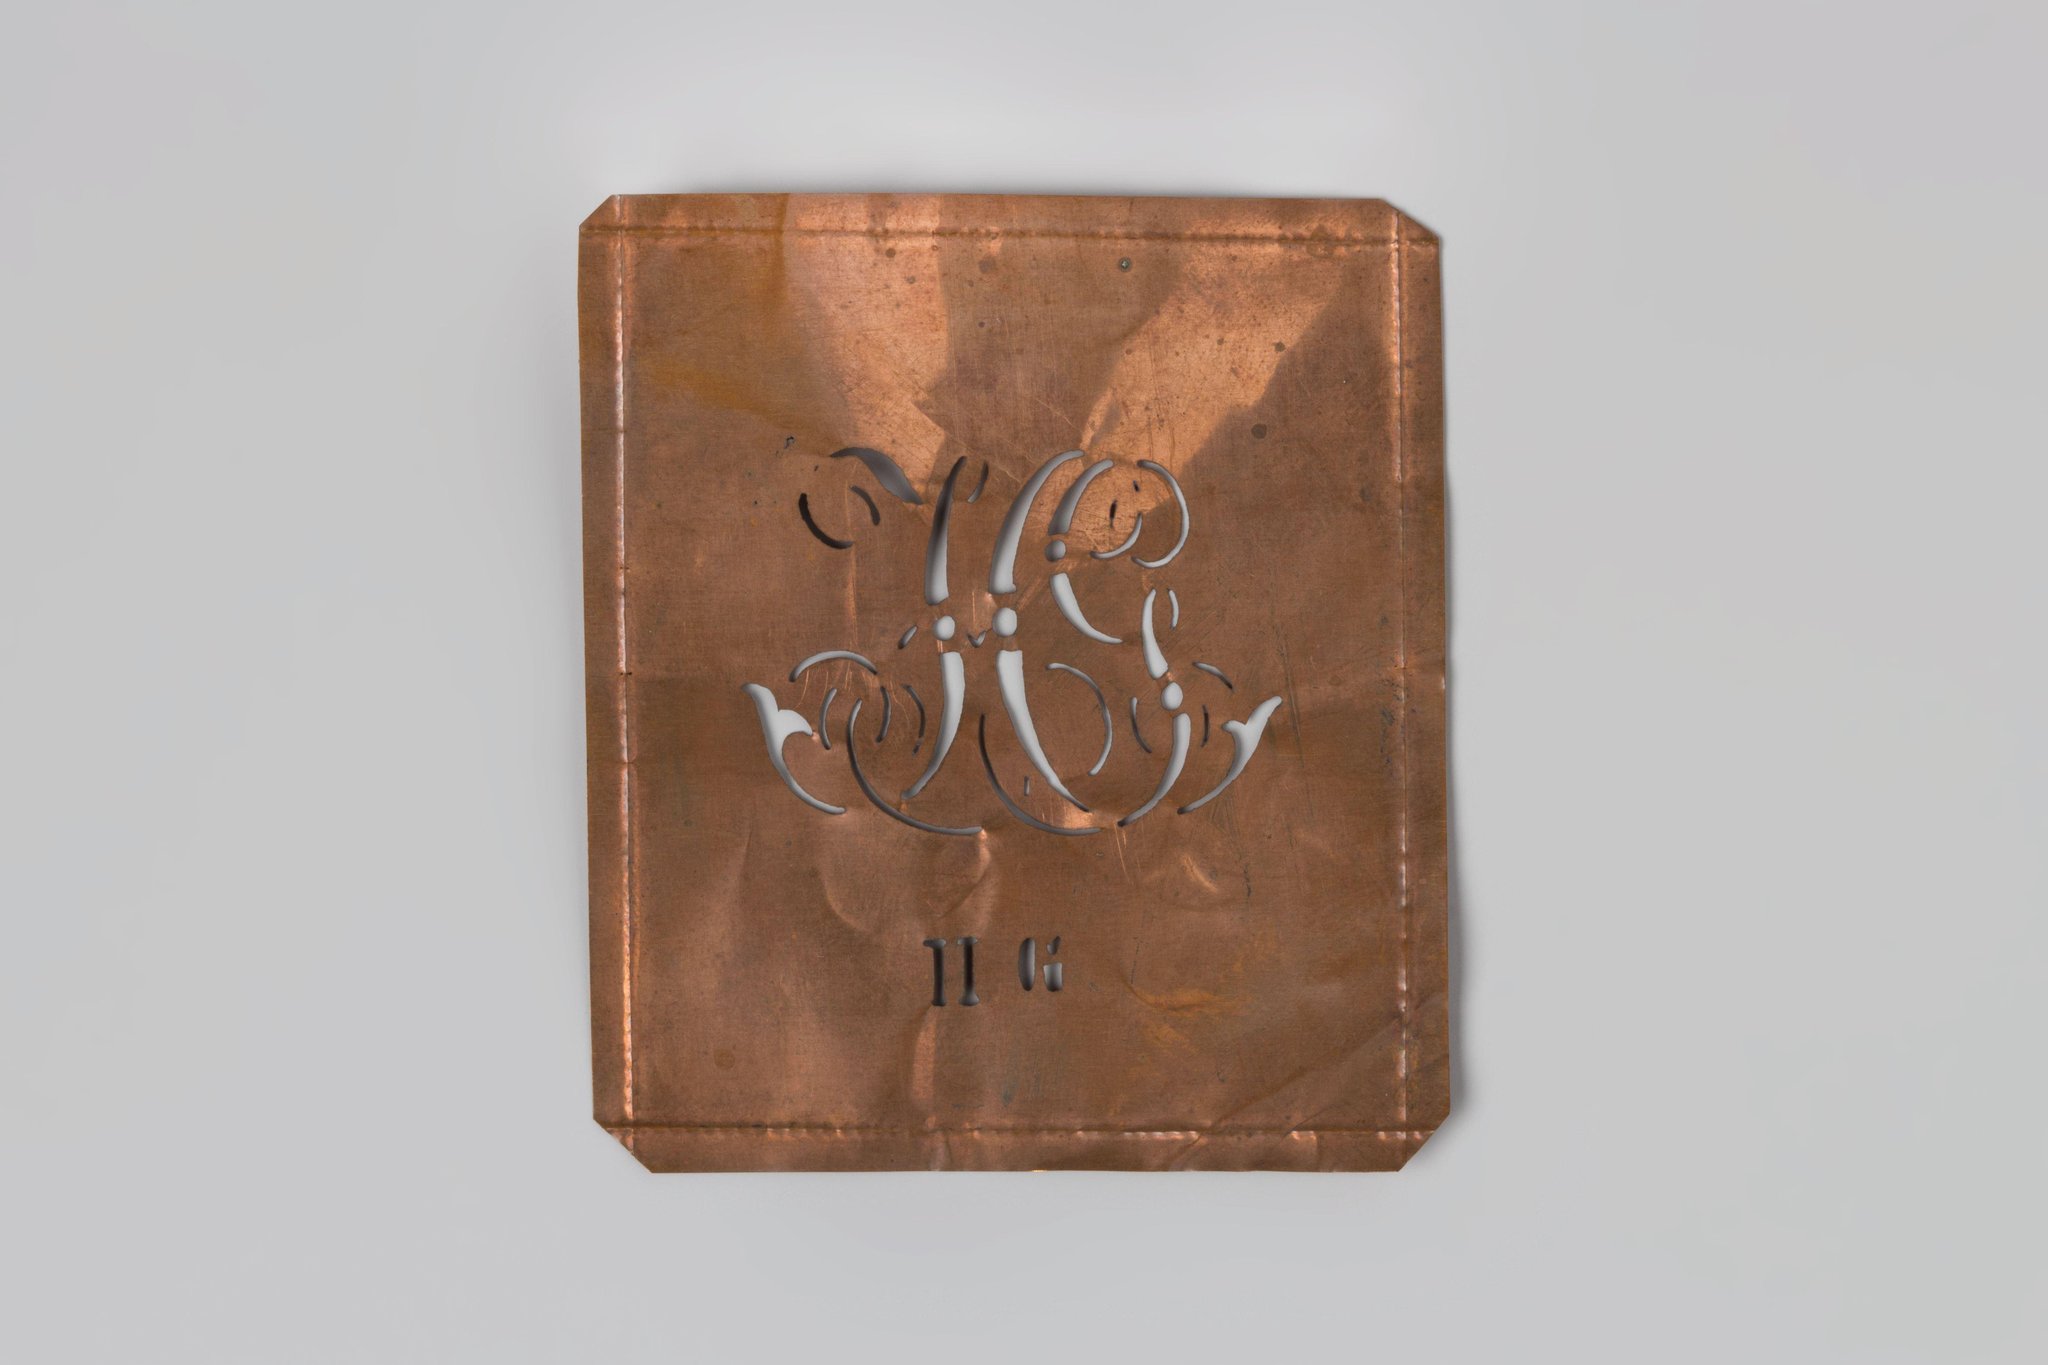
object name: template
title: Sjabloon van rood koper, rechthoekig, met uitgestanste initialen 'HG', zeer fijn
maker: Anonymous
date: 1900-1925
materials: copper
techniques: manufacturing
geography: netherlands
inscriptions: initials: ‘'HG'’, inscription: ‘'II G'’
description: Sjabloon van rood koper, voor initiaal HG. Rechthoekig, met vouwrandjes en de calligrafische letters uitgelegd onderaan. Zeer fijn.